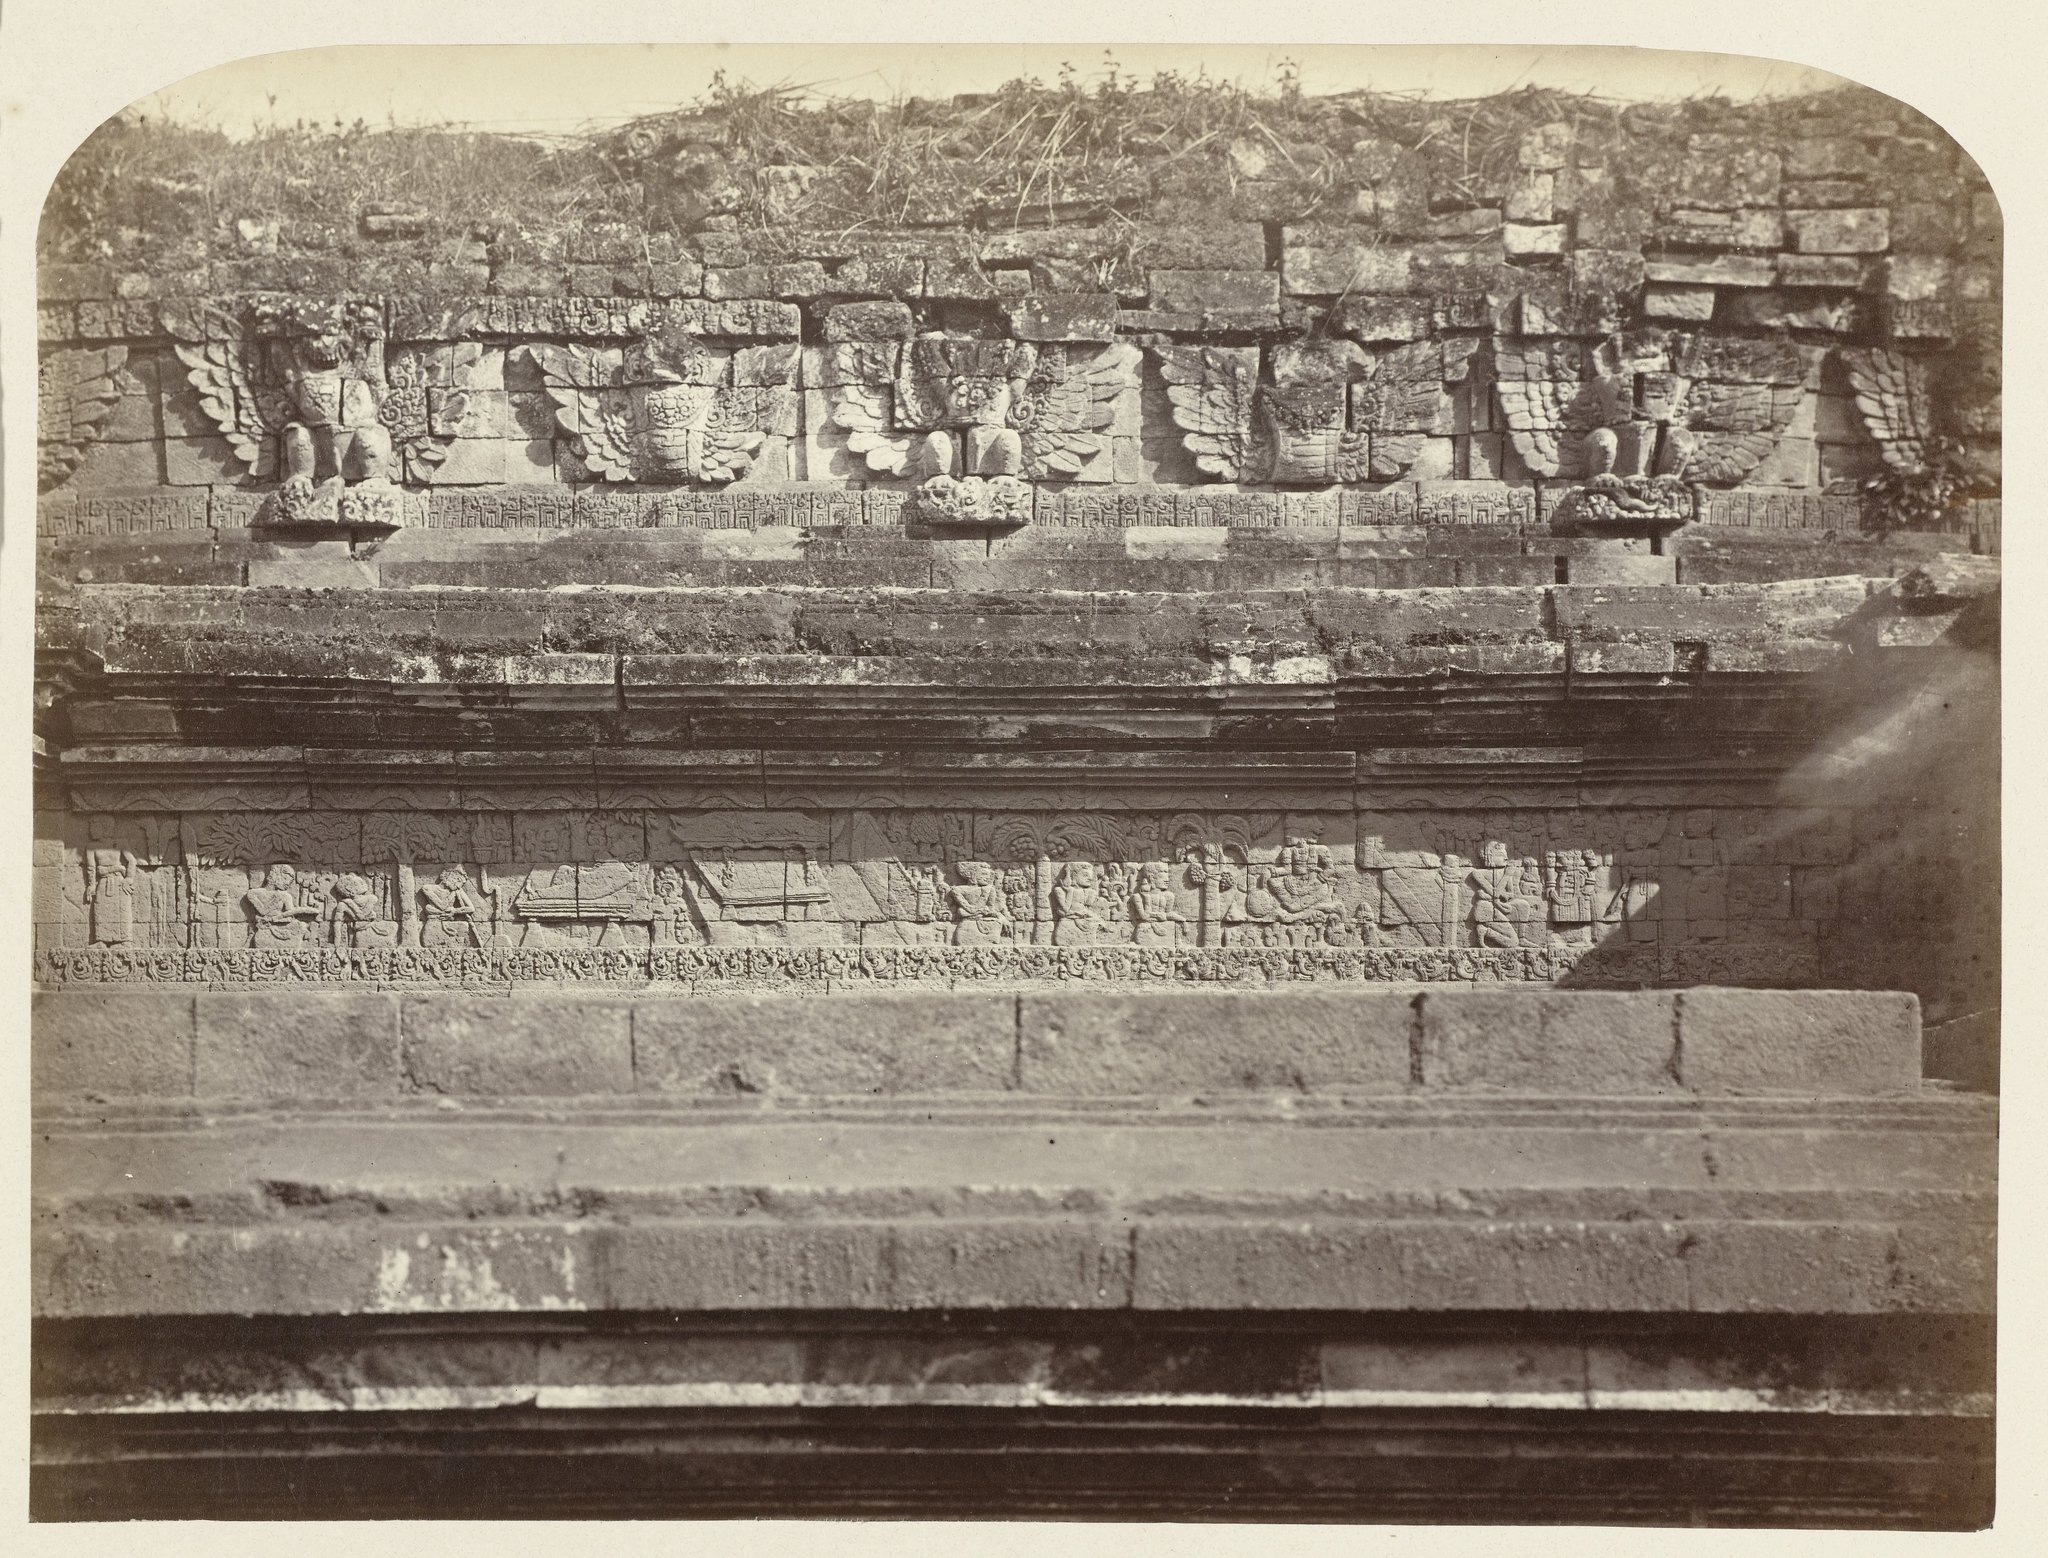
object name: photograph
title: Basreliëf van den tempel (noordzijde) 1e gaanderij [sic]. Panataran (r. Kediri)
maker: isidore kinsbergen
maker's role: fotograaf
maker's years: 1821-1905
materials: cardboard, paper, photographic support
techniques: albumen print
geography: java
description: Candi Panataran (Temple Complex), main Temple; Krishnayana relief no 13 (Krishna receives advice, stops eating and sleeps on a couch), second narrative register east side. Panataran, Blitar district, East Java province 1323-1347 AD.